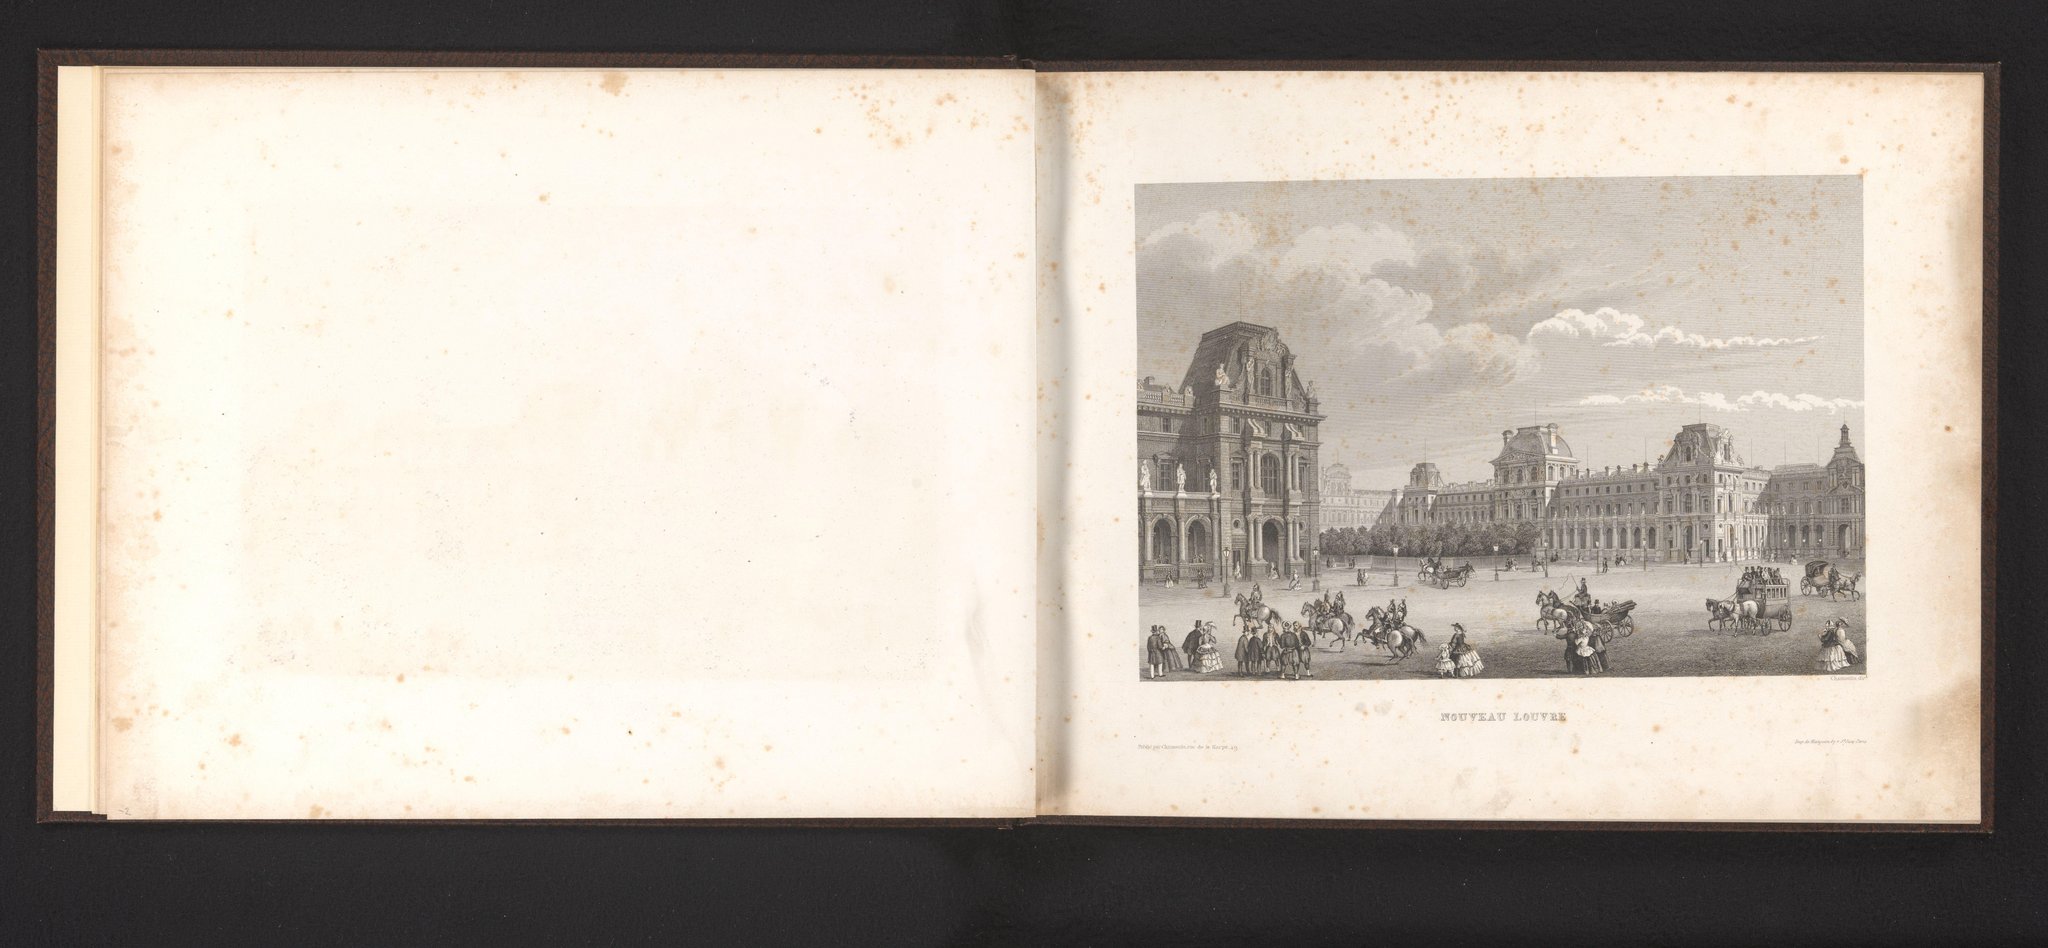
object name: print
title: Gezicht op het Palais du Louvre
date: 1845-1850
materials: paper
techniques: engraving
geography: paris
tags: palace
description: Prent op derde ongenummerde pagina na titelpagina. Prent gemaakt naar daguerreotypie.